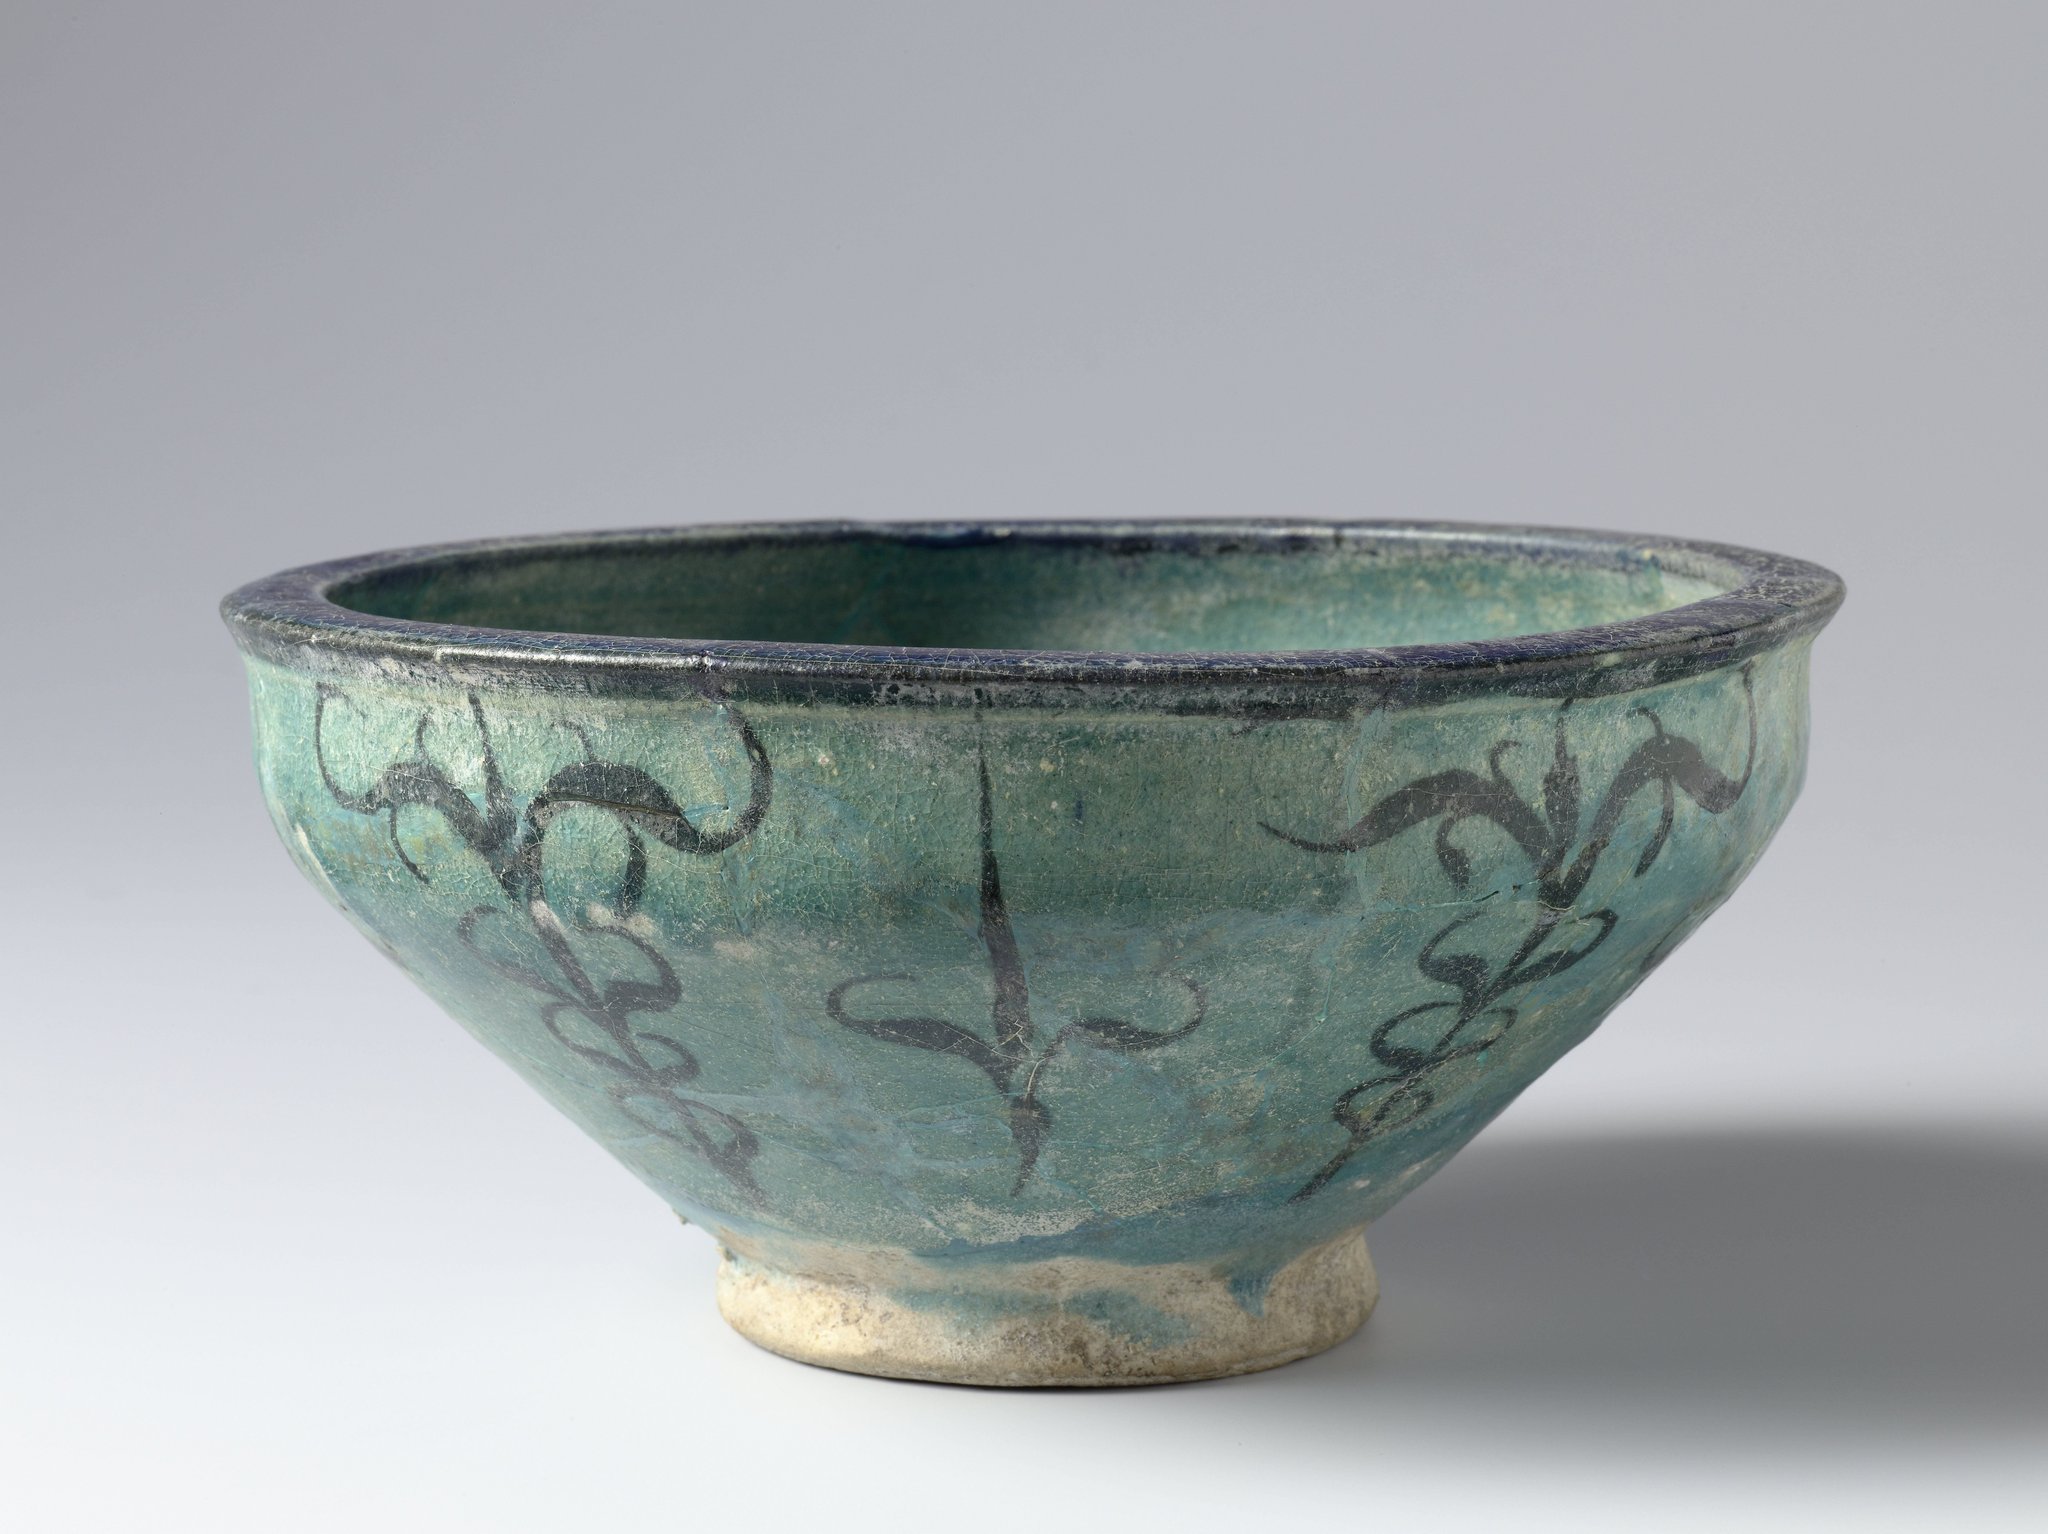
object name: bowl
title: Bowl with stylized petal motifs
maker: Anonymous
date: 1275-1324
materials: cobalt, earthenware, glaze, paint, quartz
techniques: firing, turning, vitrification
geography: kashan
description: Kom van kwarts-fritgoed met een beschildering in blauw van gestileerde bladmotieven onder een transparant turquoise alkaliglazuur.